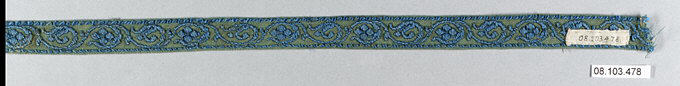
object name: galloon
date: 1830